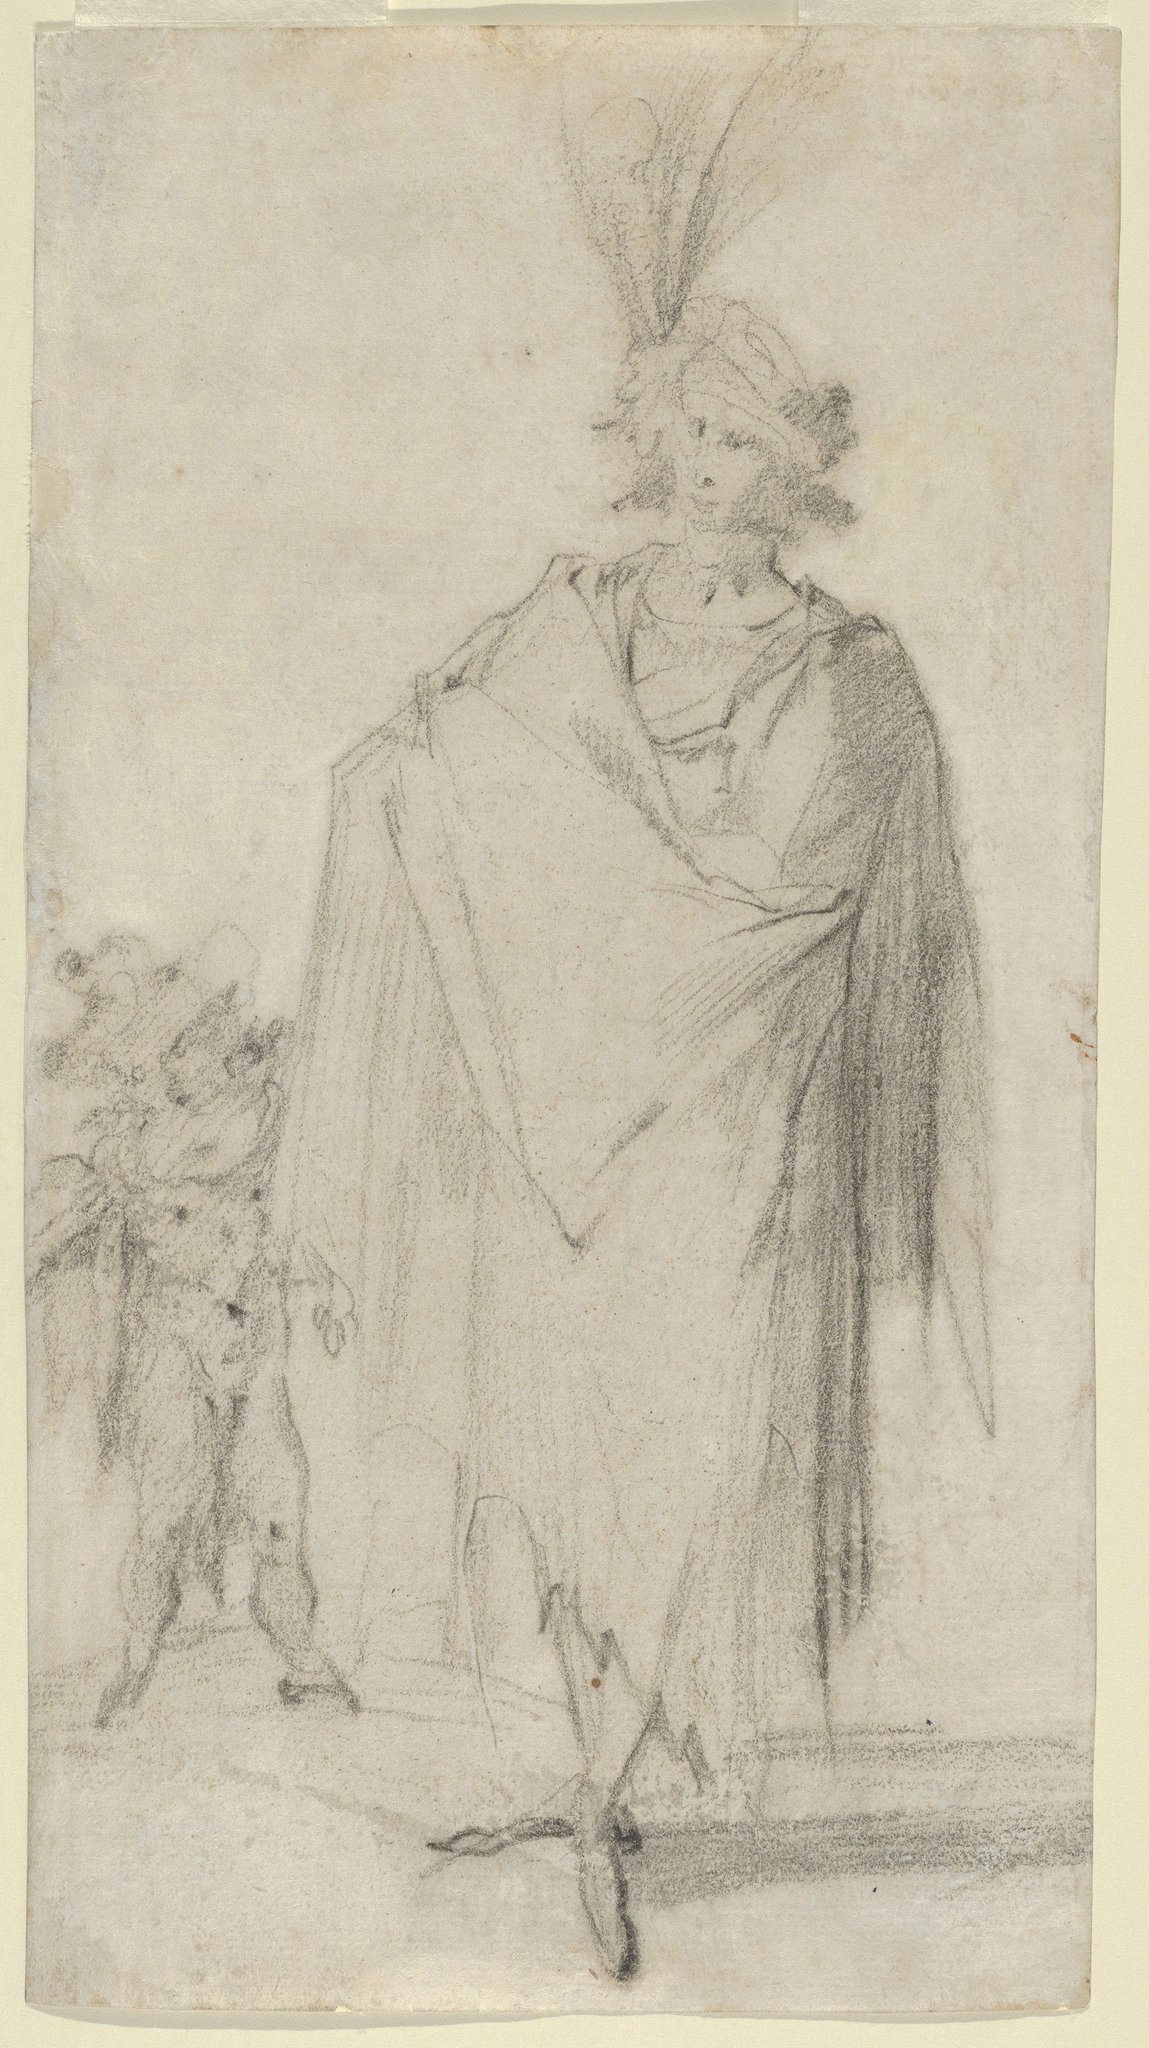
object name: drawing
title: Standing Man with a Putto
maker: jacques bellange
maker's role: artist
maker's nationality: french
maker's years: 1575-1616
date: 1575-1616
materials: chalk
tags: men,putti